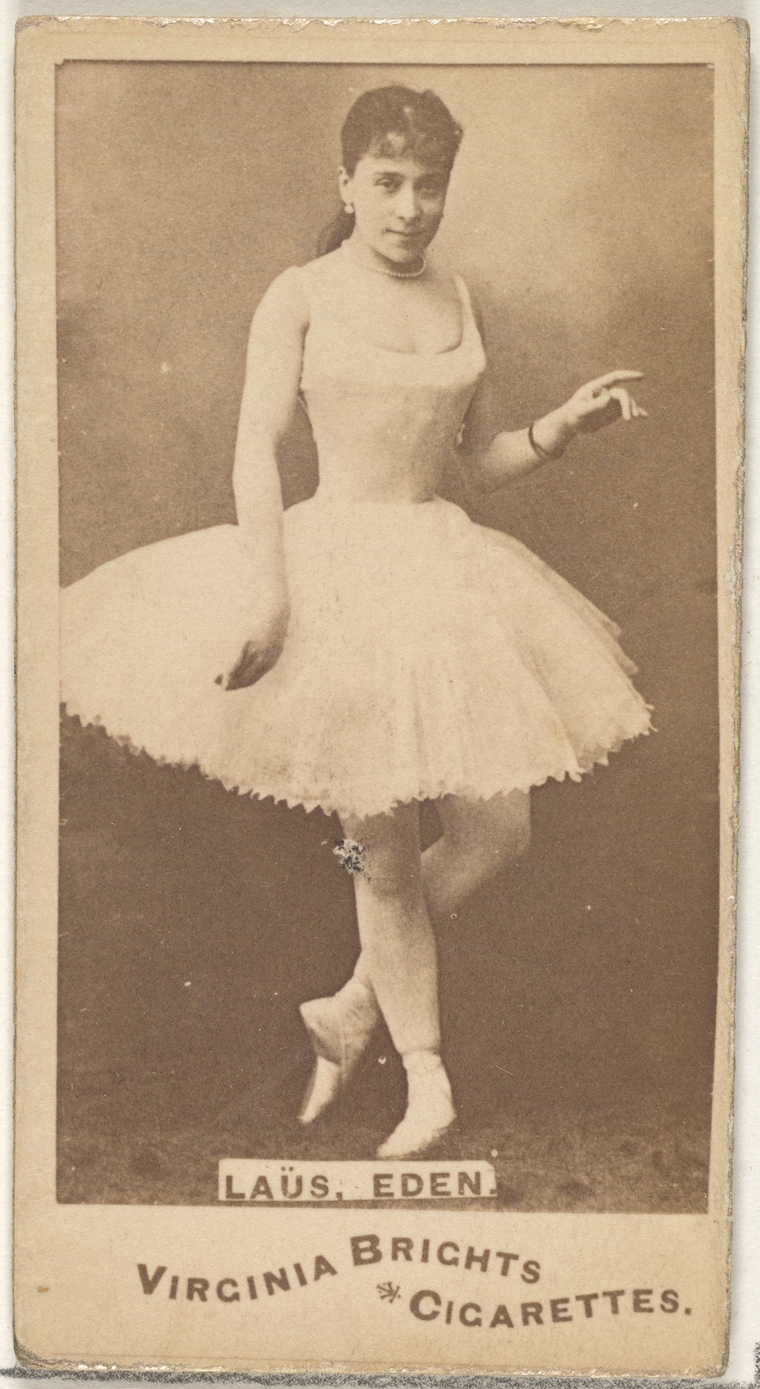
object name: photograph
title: Laus, Eden, from the Actors and Actresses series (N45, Type 1) for Virginia Brights Cigarettes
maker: allen & ginter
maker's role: publisher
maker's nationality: american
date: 1888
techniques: albumen silver print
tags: portraits,women,actresses